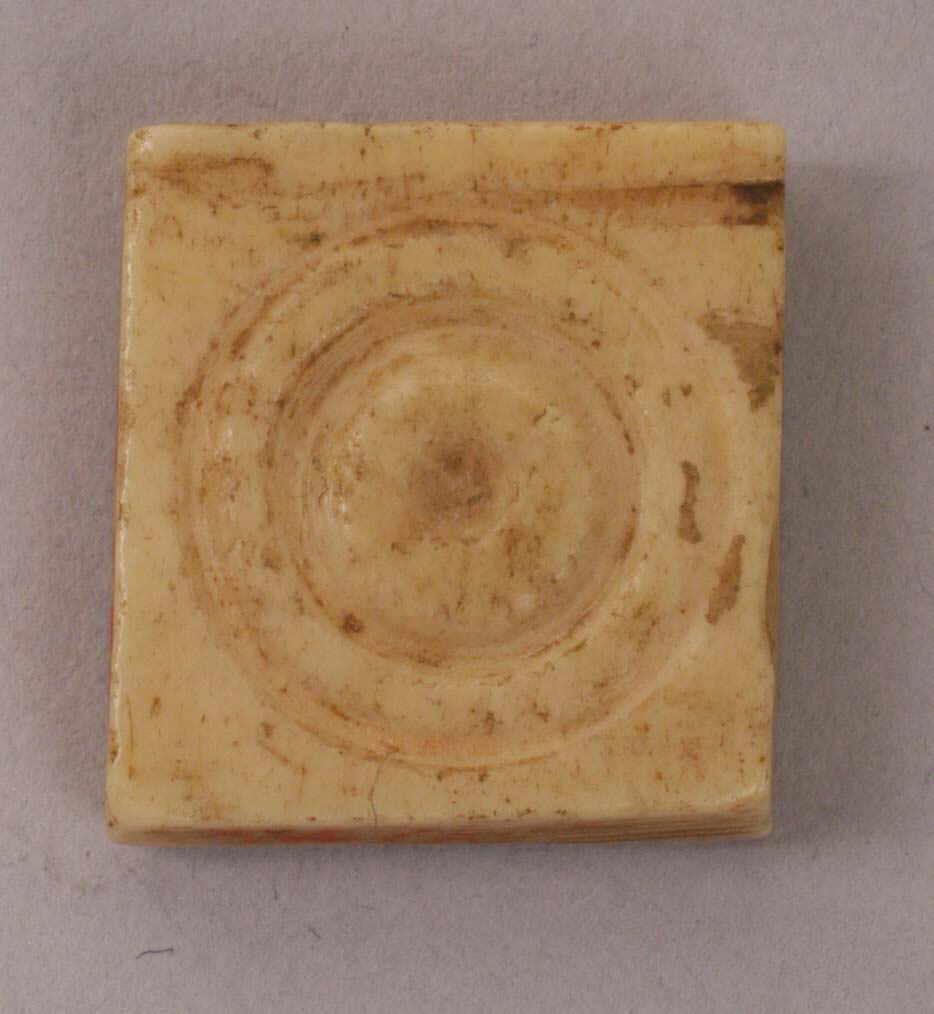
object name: counter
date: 30 BCE-364 CE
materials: bone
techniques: carving, incising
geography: egypt